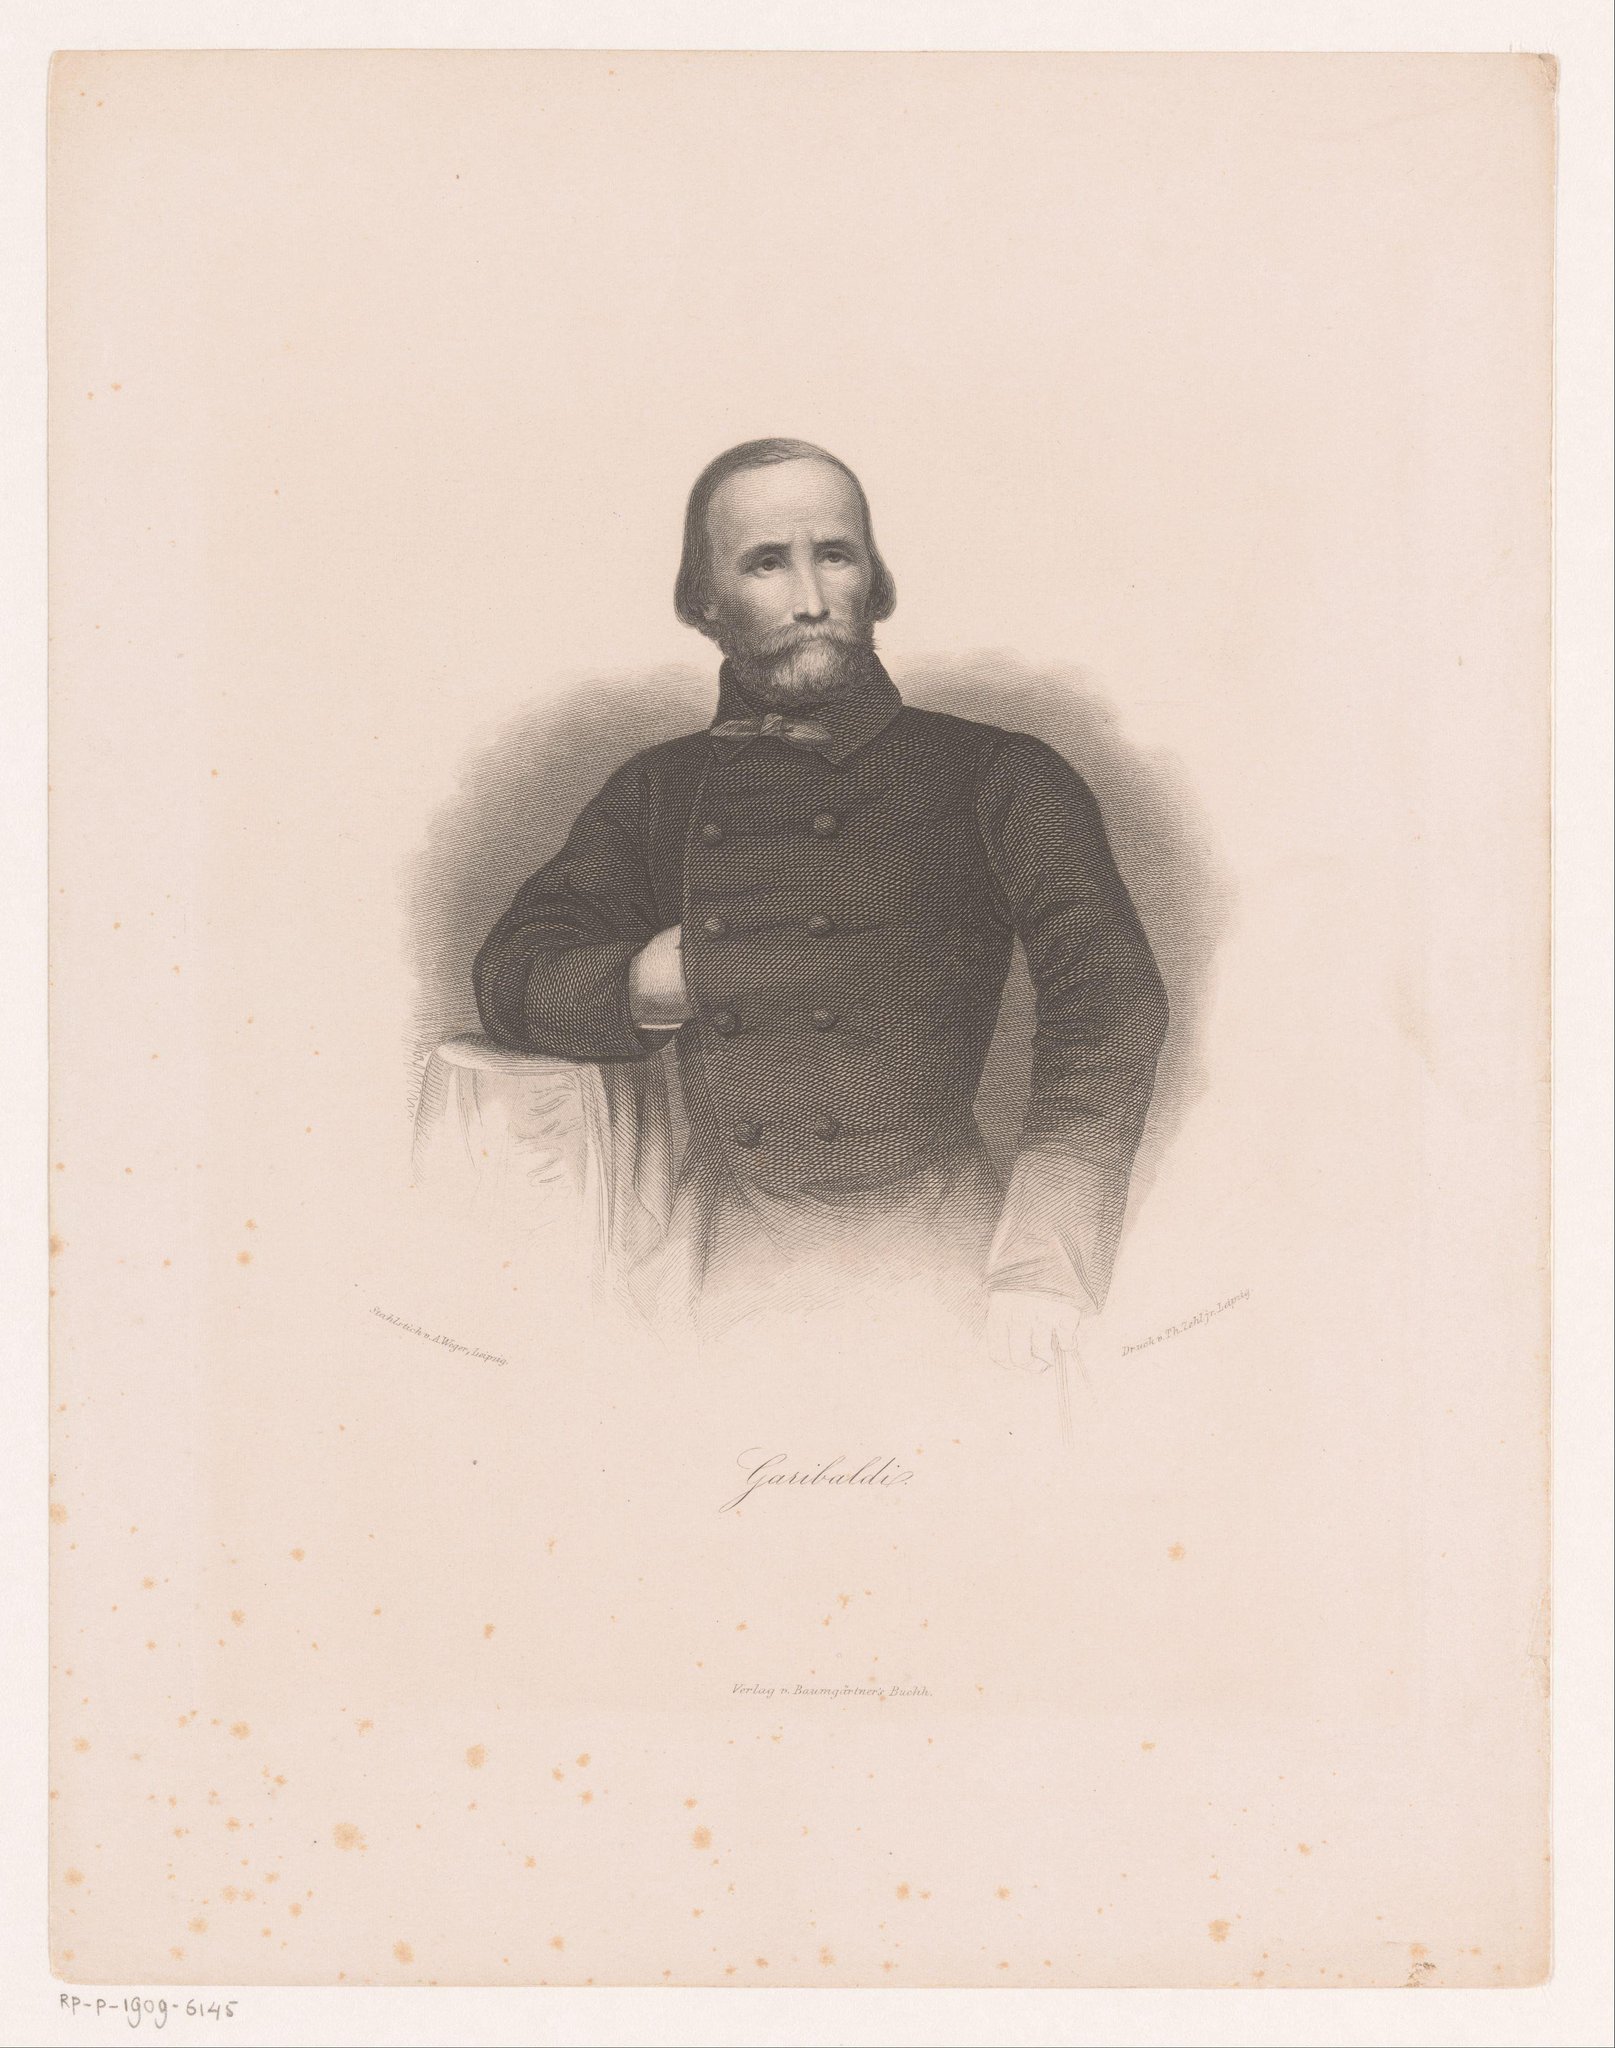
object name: print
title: Portret van Giuseppe Garibaldi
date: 1849-1892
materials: paper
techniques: engraving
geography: leipzig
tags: historical persons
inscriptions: collector's mark: Lugt 2228